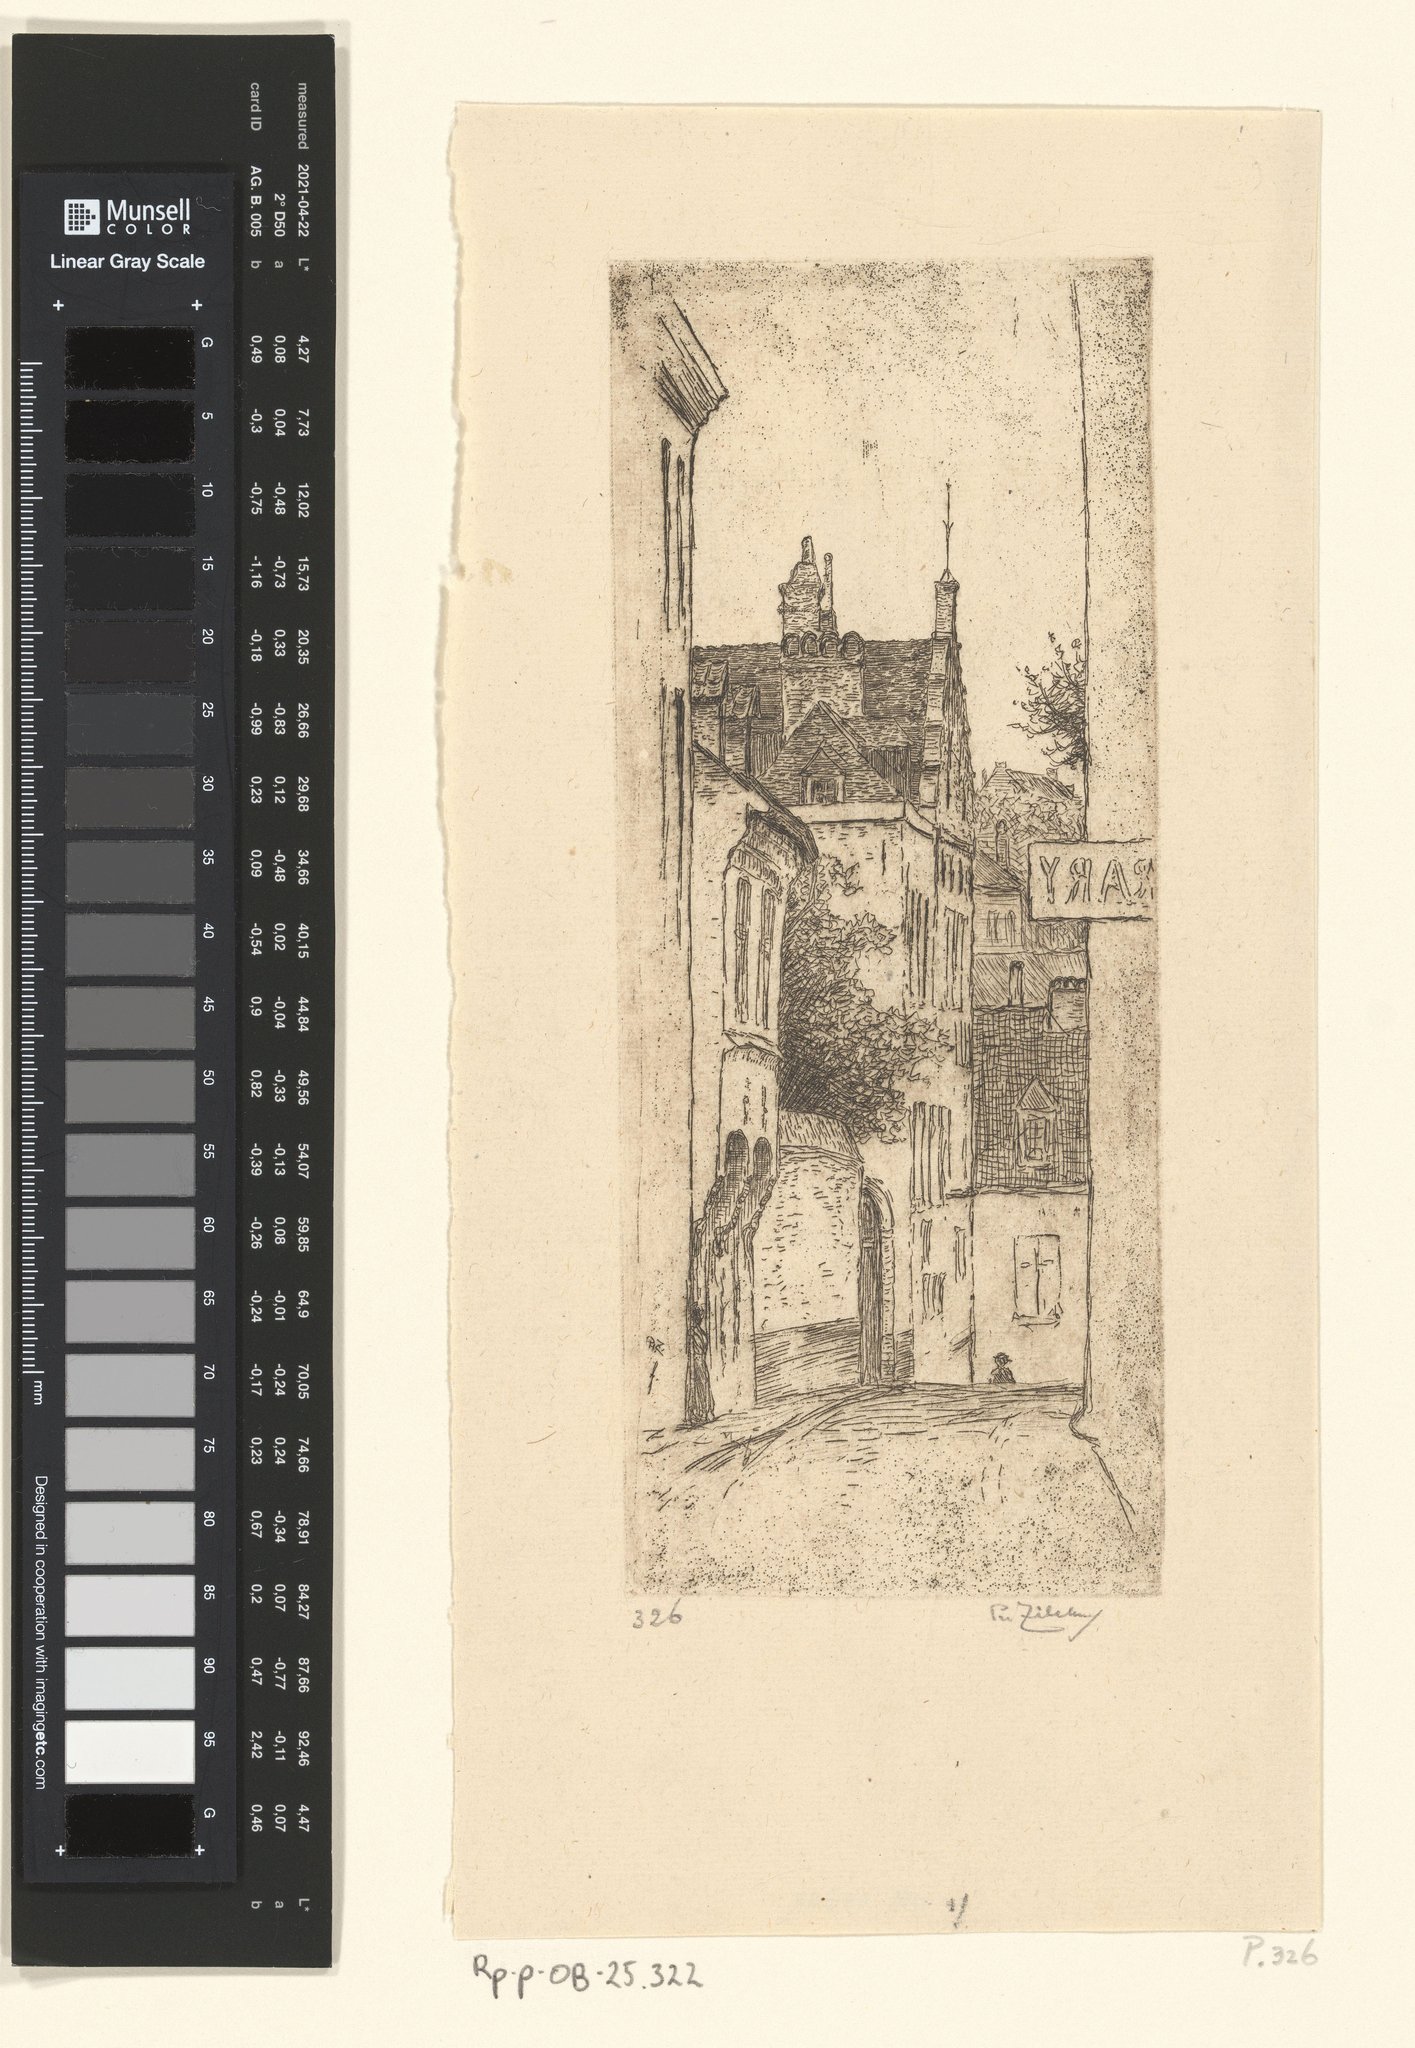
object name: print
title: Gezicht in de Ravensteinstraat te Brussel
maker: philip zilcken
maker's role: draughtsman, painter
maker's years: 1857-1930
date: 1890-1930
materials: paper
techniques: etching, intaglio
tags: street, brussels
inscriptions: collector's mark: Lugt 2228, collector's mark: Lugt 2760